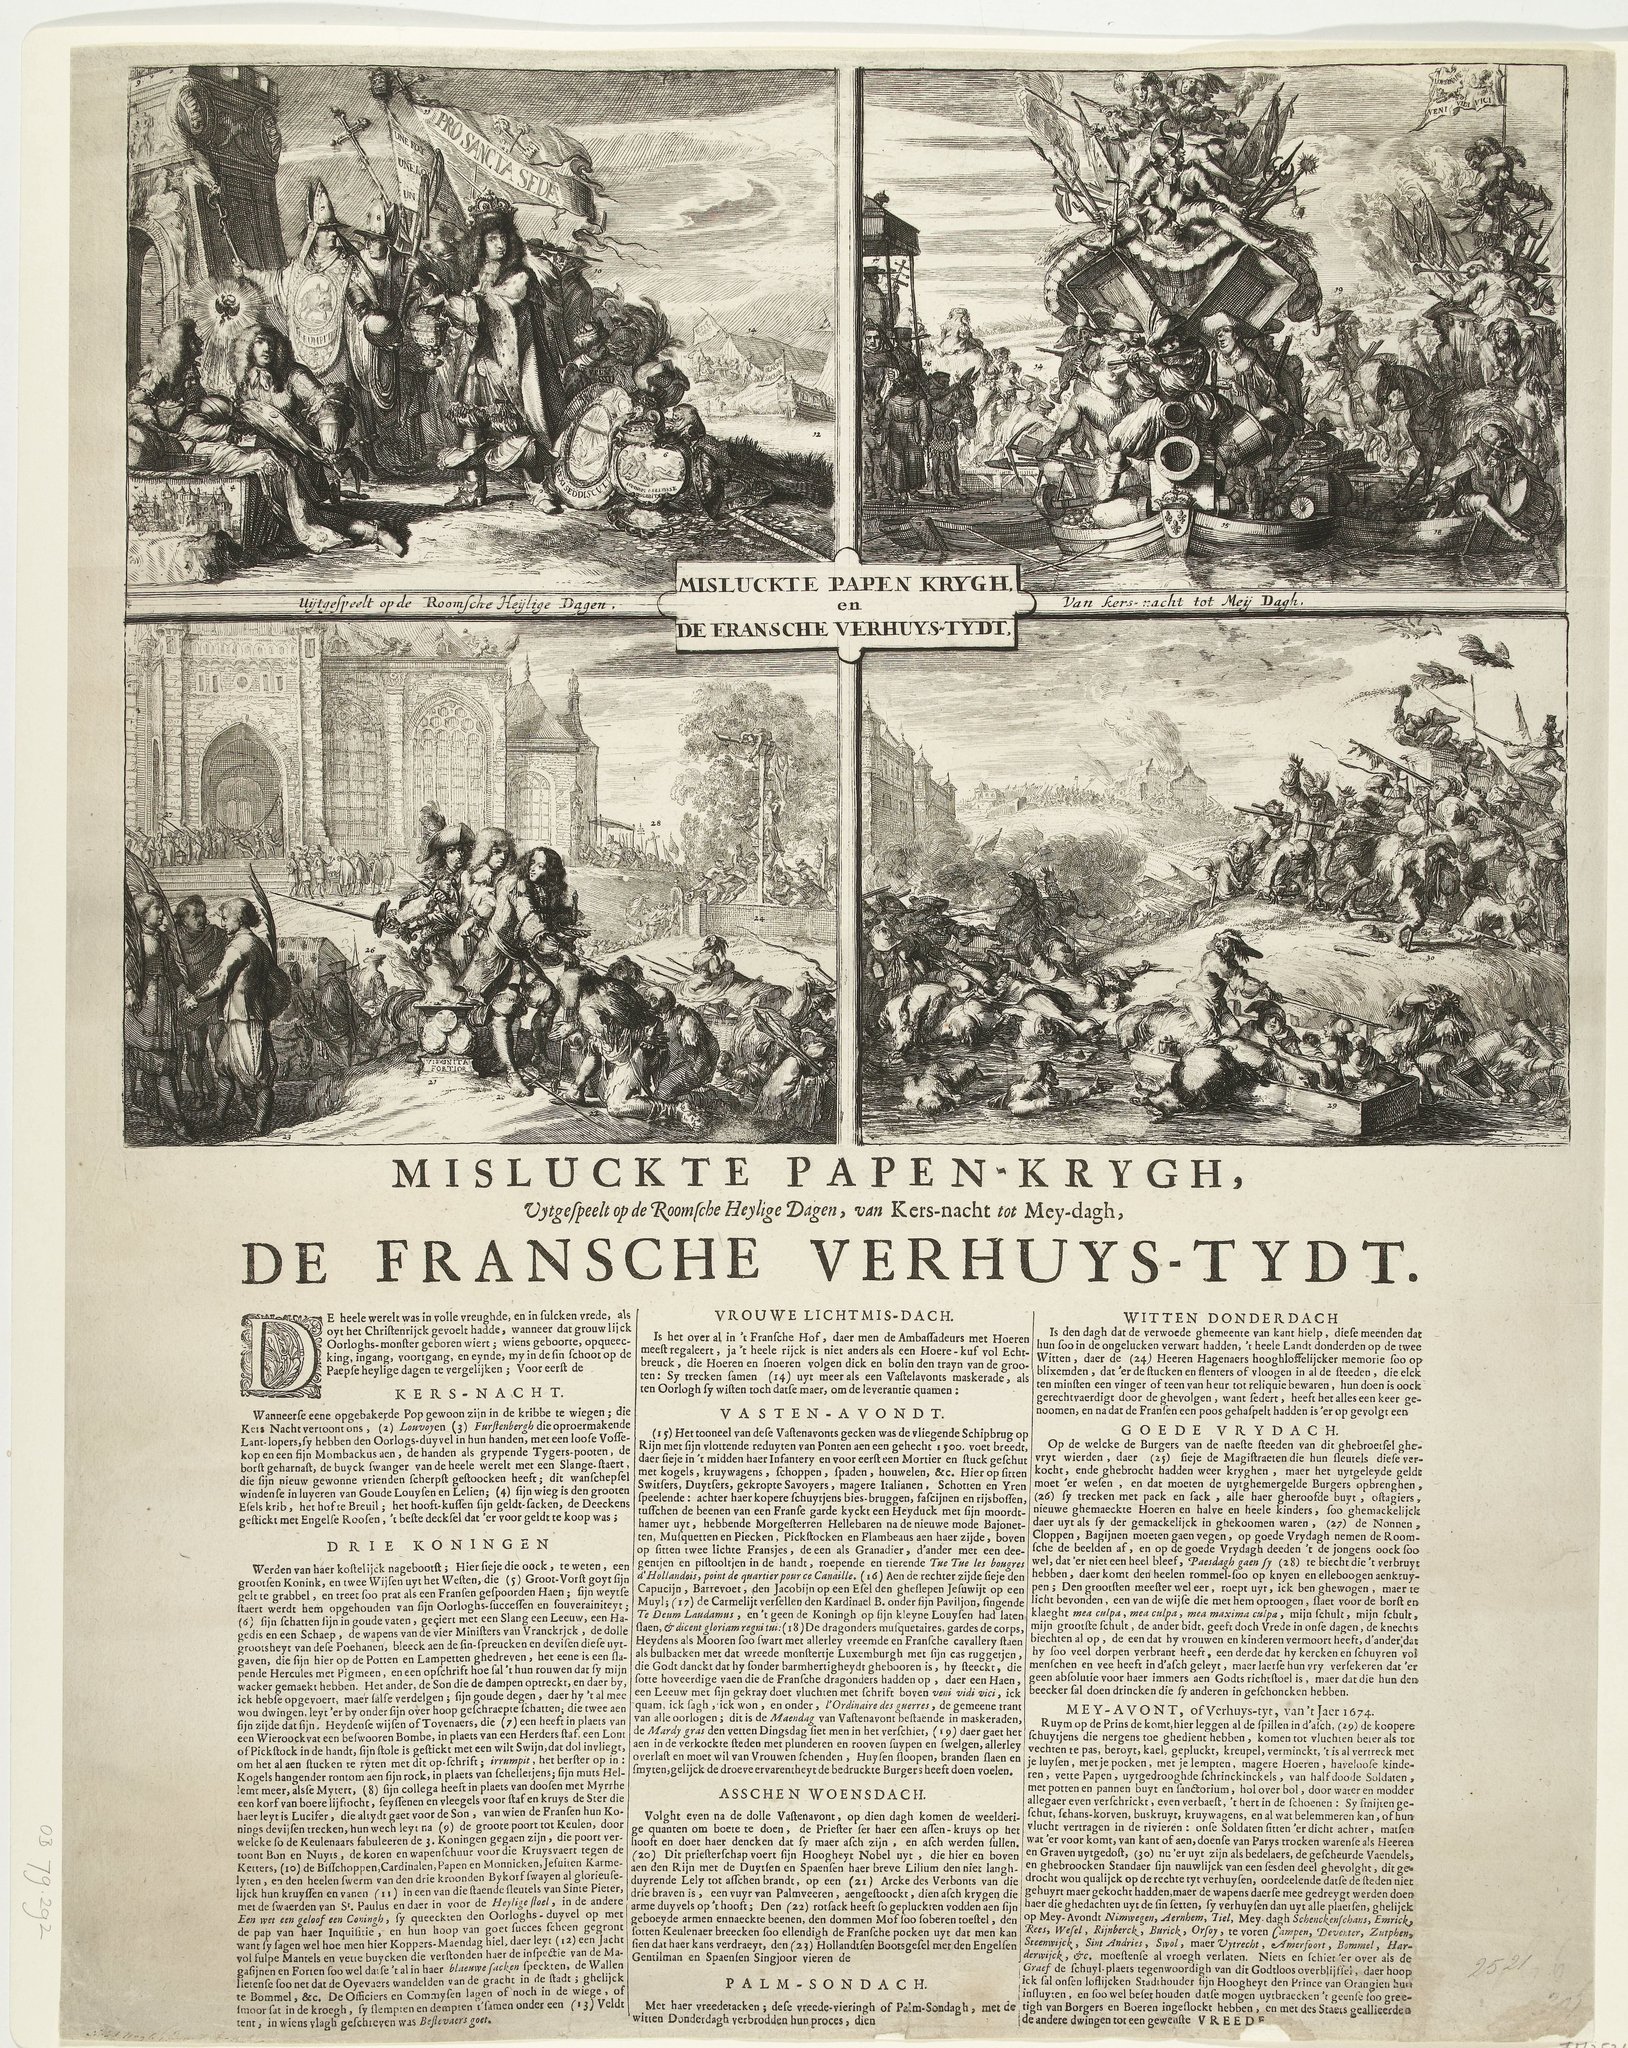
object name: propagandaprent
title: Spotprent op de oorlog met Frankrijk, 1674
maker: romeyn de hooghe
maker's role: draughtsman, goldsmith, painter, print maker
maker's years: 1645-1708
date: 1674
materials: paper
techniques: etching, letterpress printing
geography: northern netherlands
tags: william iii (prince of orange and king of england, scotland, and ireland), lodewijk xiv (koning van frankrijk), maximiliaan hendrik van beieren, françois-michel le tellier (markies de louvois), paris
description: Spotprent op de oorlog met Frankrijk in vier scènes. Linksboven de aanvang van de oorlog in 1672 met Lodewijk XIV de bisschoppen van Keulen en Münster, minister Louvois en kardinaal Fürstenberg, rechtsboven de schipbrug over de Rijn met zwaarbeladen boten en wagens, linksonder geeft Willem III de Fransen als boetedoening een askruis en op de achtergrond de moord op de gebroeders de Witt, rechtsonder worden in 1674 de Fransen weer uit het land verjaagd. Onder de voorstelling een tekstblad met in 3 kolommen een versluierde beschrijving van de gebeurtenissen volgens de roomse feestdagen en een verklaring van de cijfers 1-30, in het Nederlands.